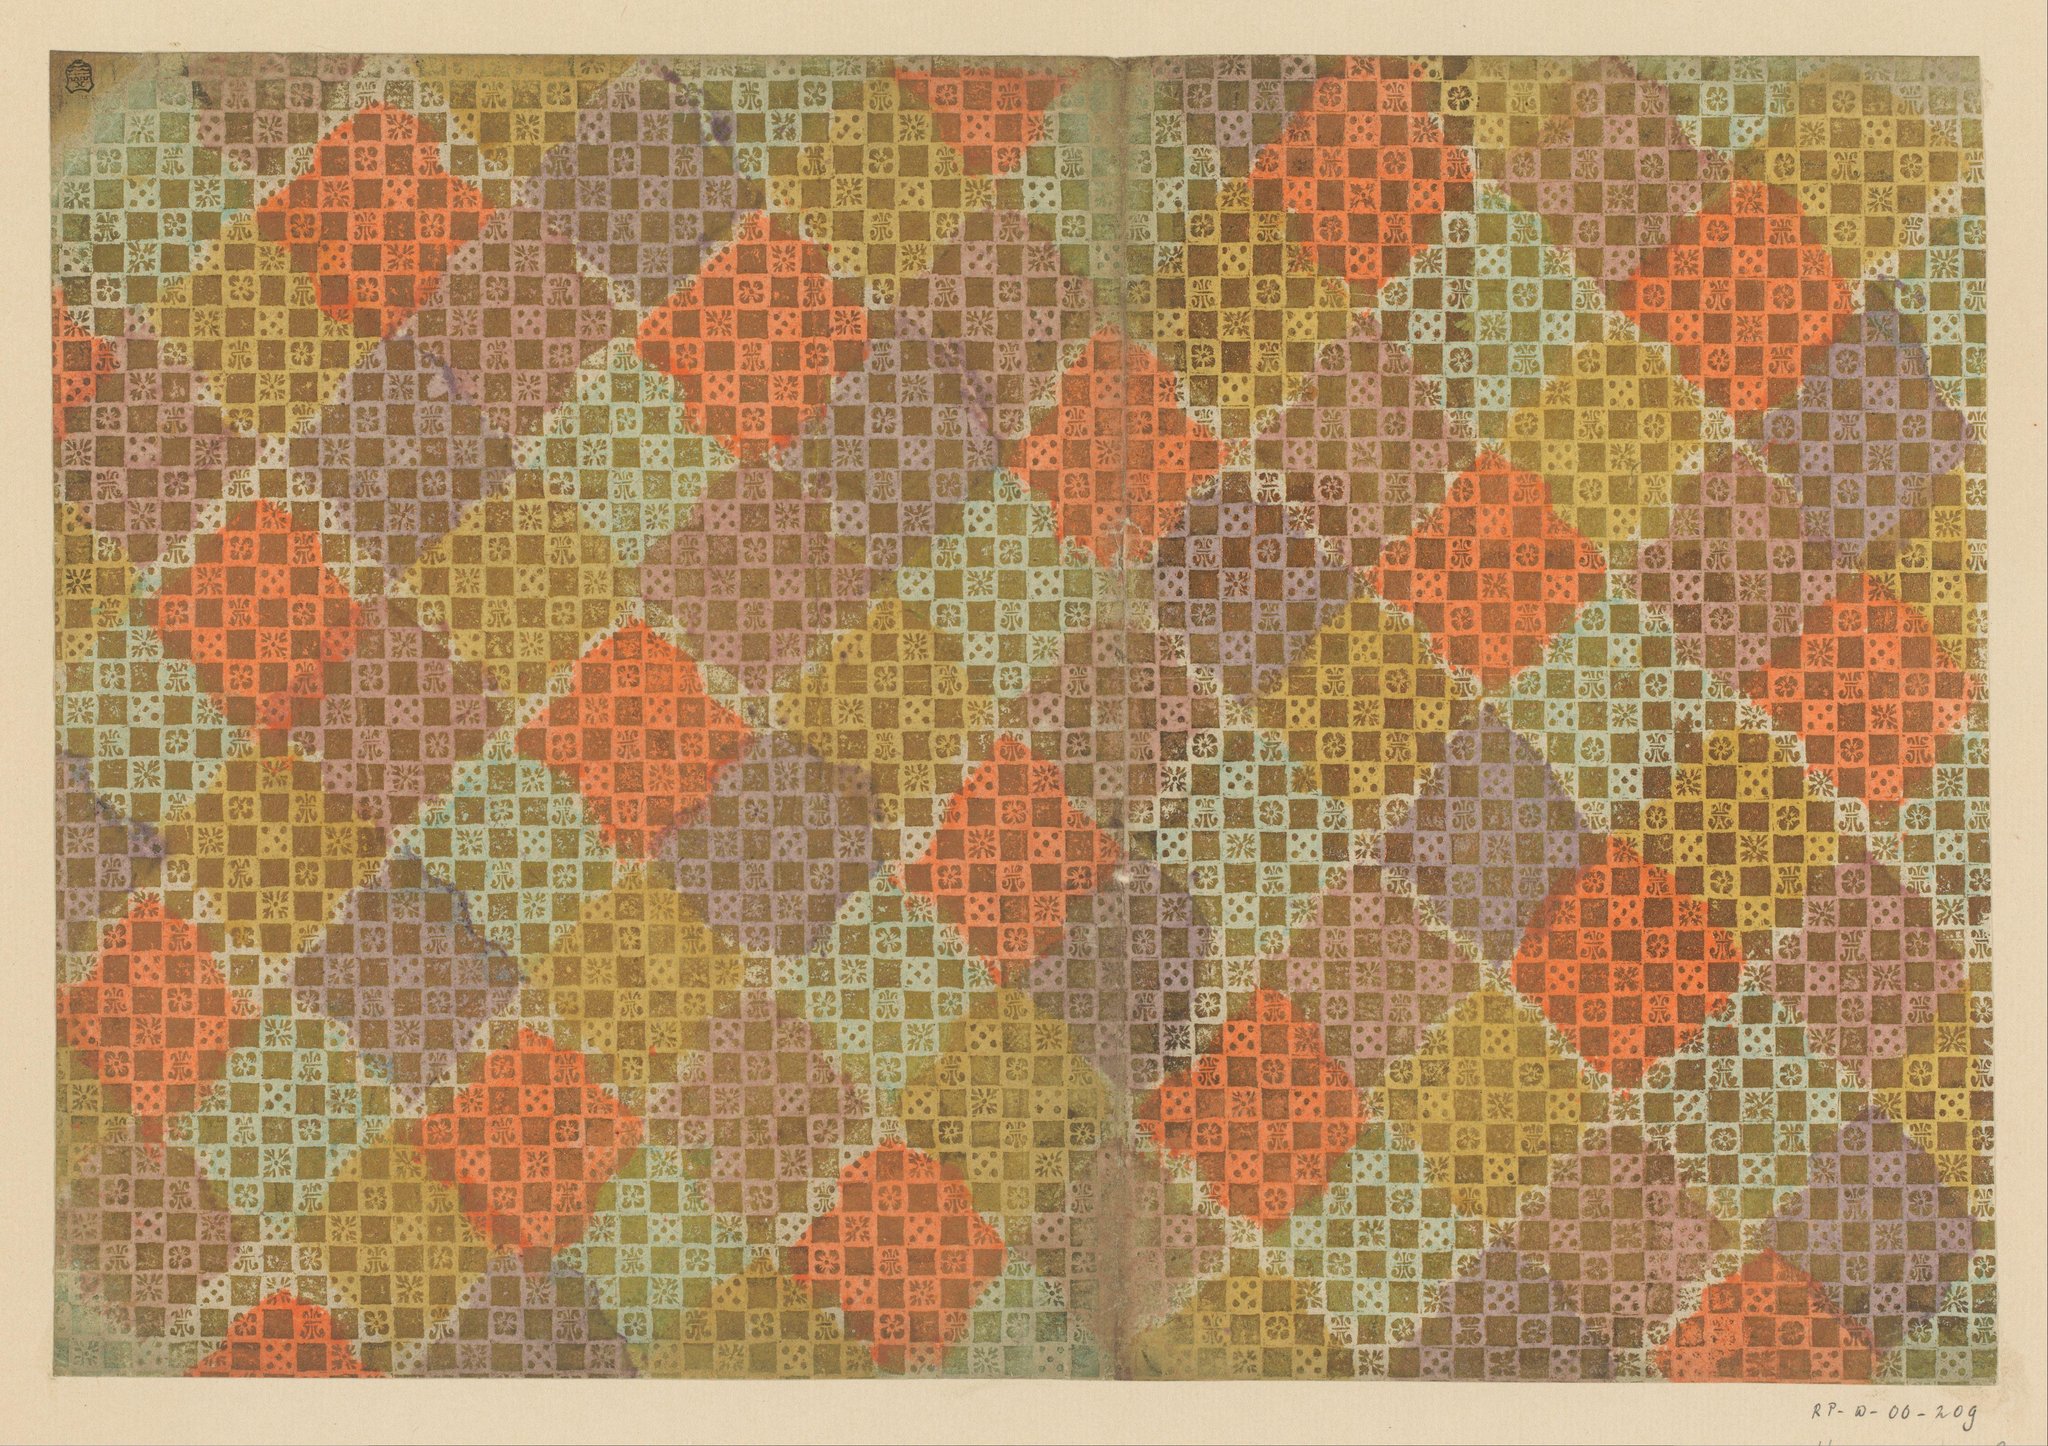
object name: brocade paper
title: Blad met schaakbordpatroon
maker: johann carl munck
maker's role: ontwerper sierpapier, papiermaker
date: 1750-1794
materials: gold leaf, paint, paper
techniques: relief print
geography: augsburg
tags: ornament ~ geometric motifs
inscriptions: collector's mark: Lugt 2760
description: Blad met schaakbordpatroon met afwisselend vierkant in geheel goud, twee soorten rozetten, dobbelsteen vijf en lelie.